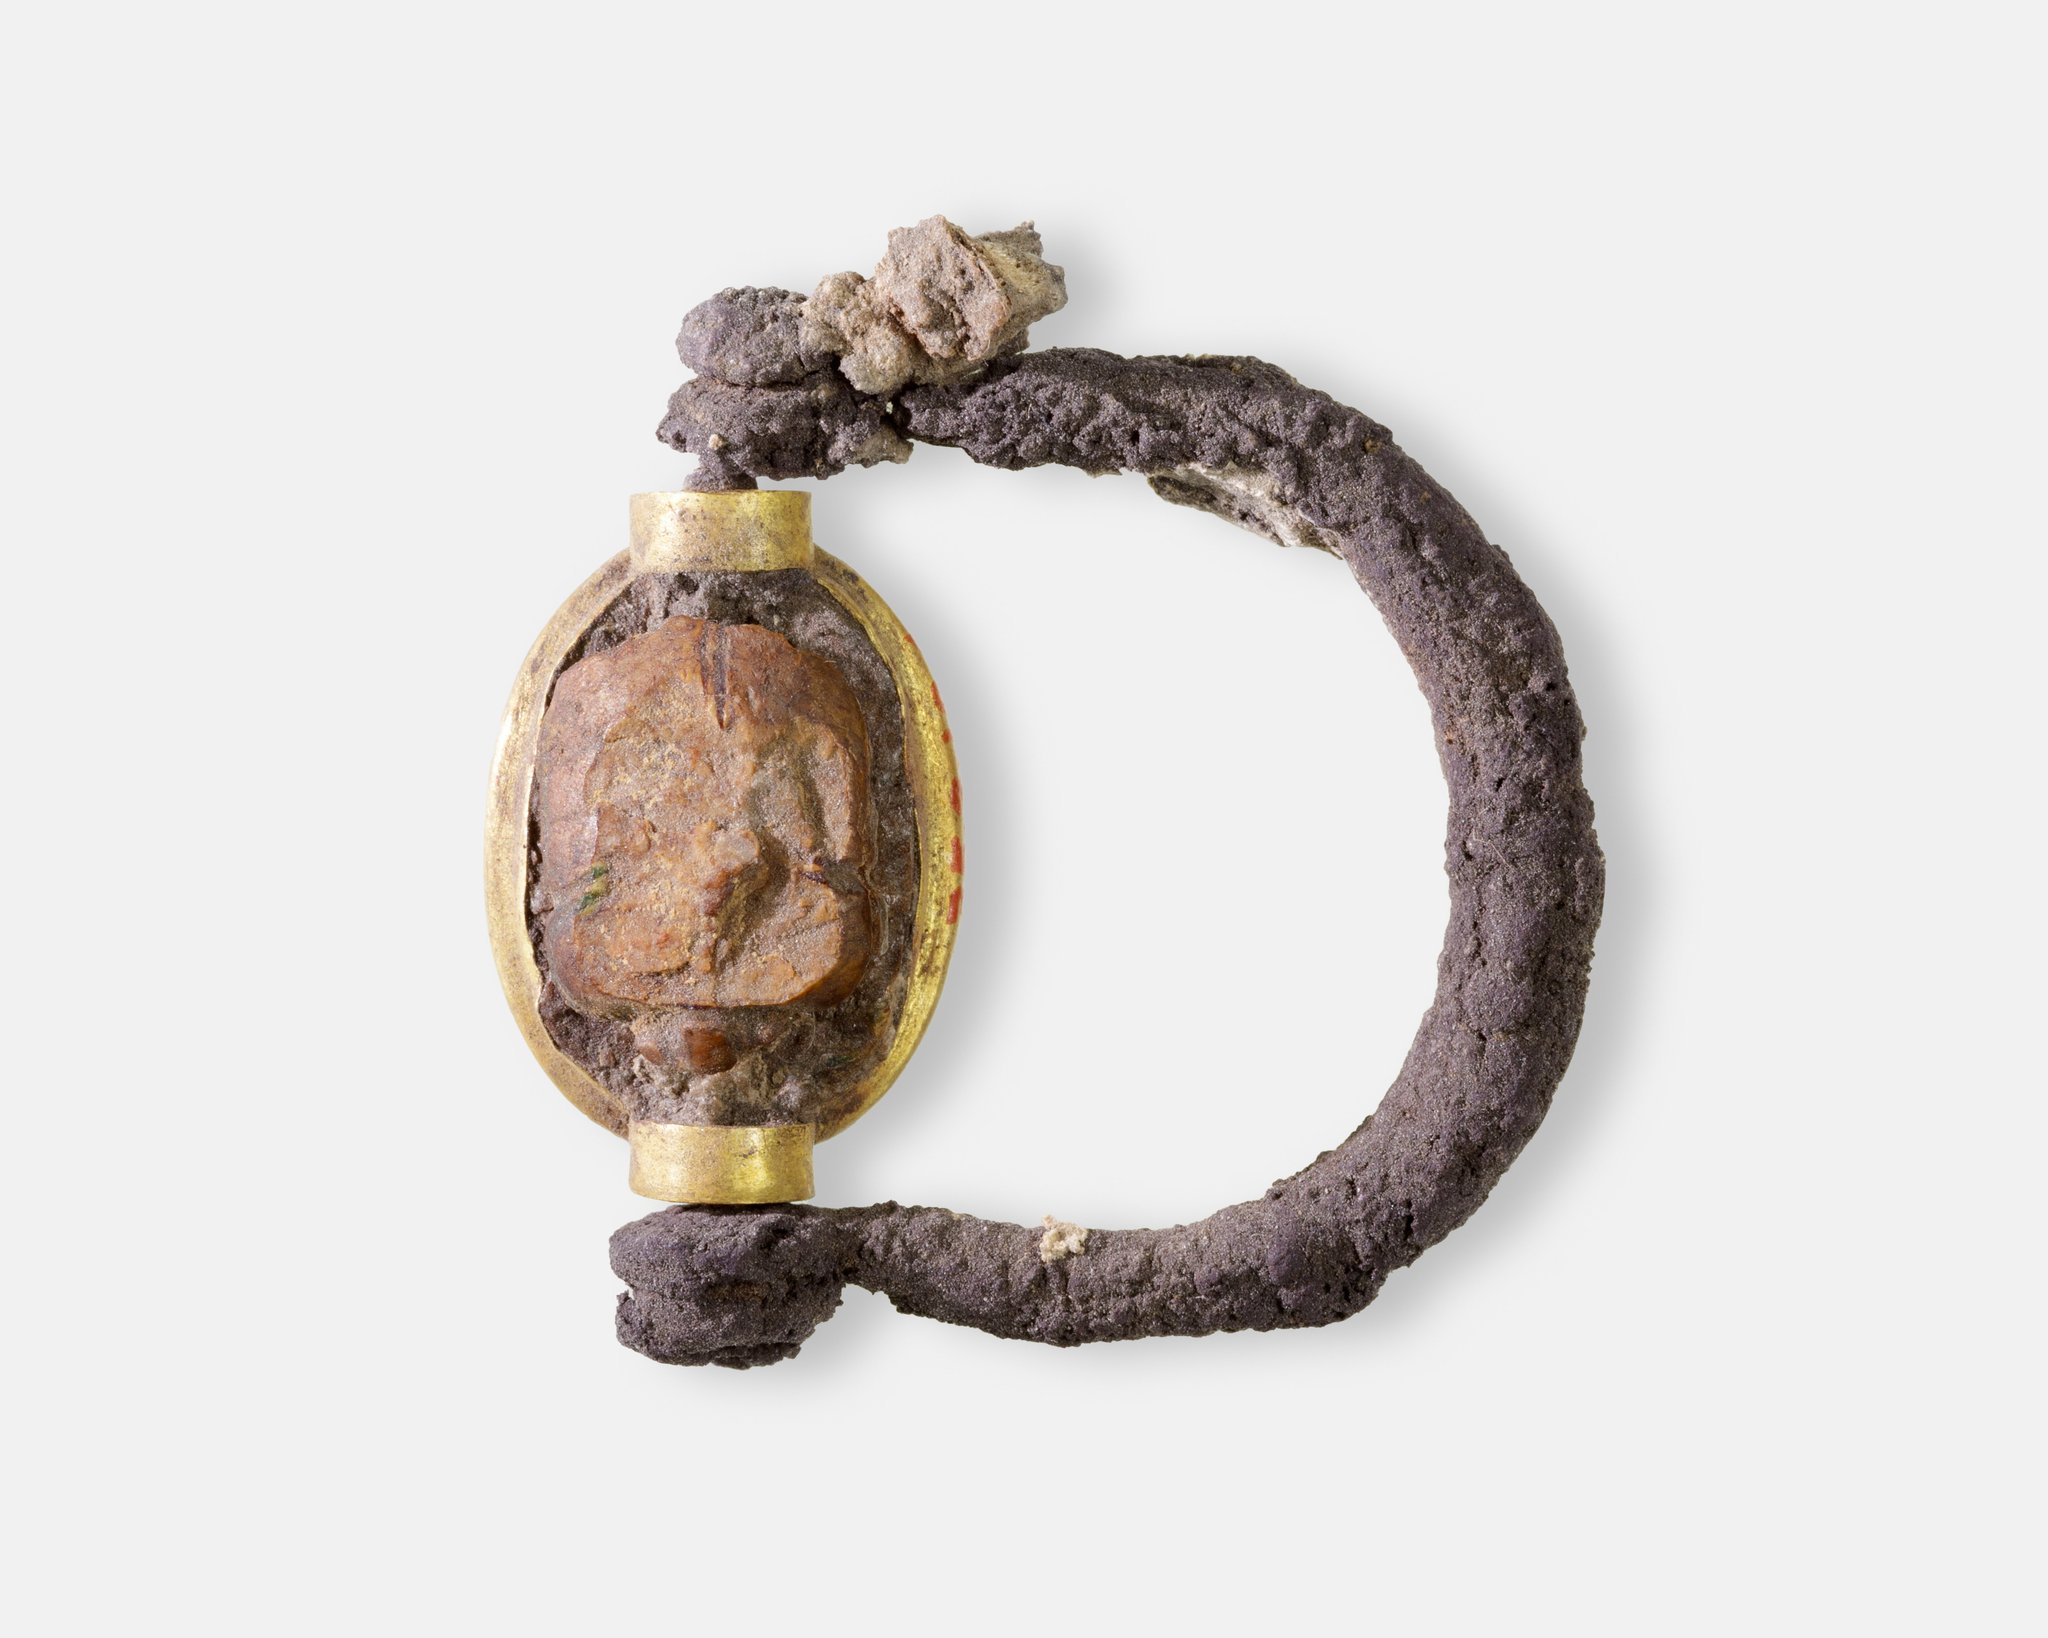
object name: ring, scarab, neferkhawet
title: Scarab Ring of Neferkhawet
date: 1504-1447 BCE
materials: gold, silver, stone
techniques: glazing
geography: egypt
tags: scarabs